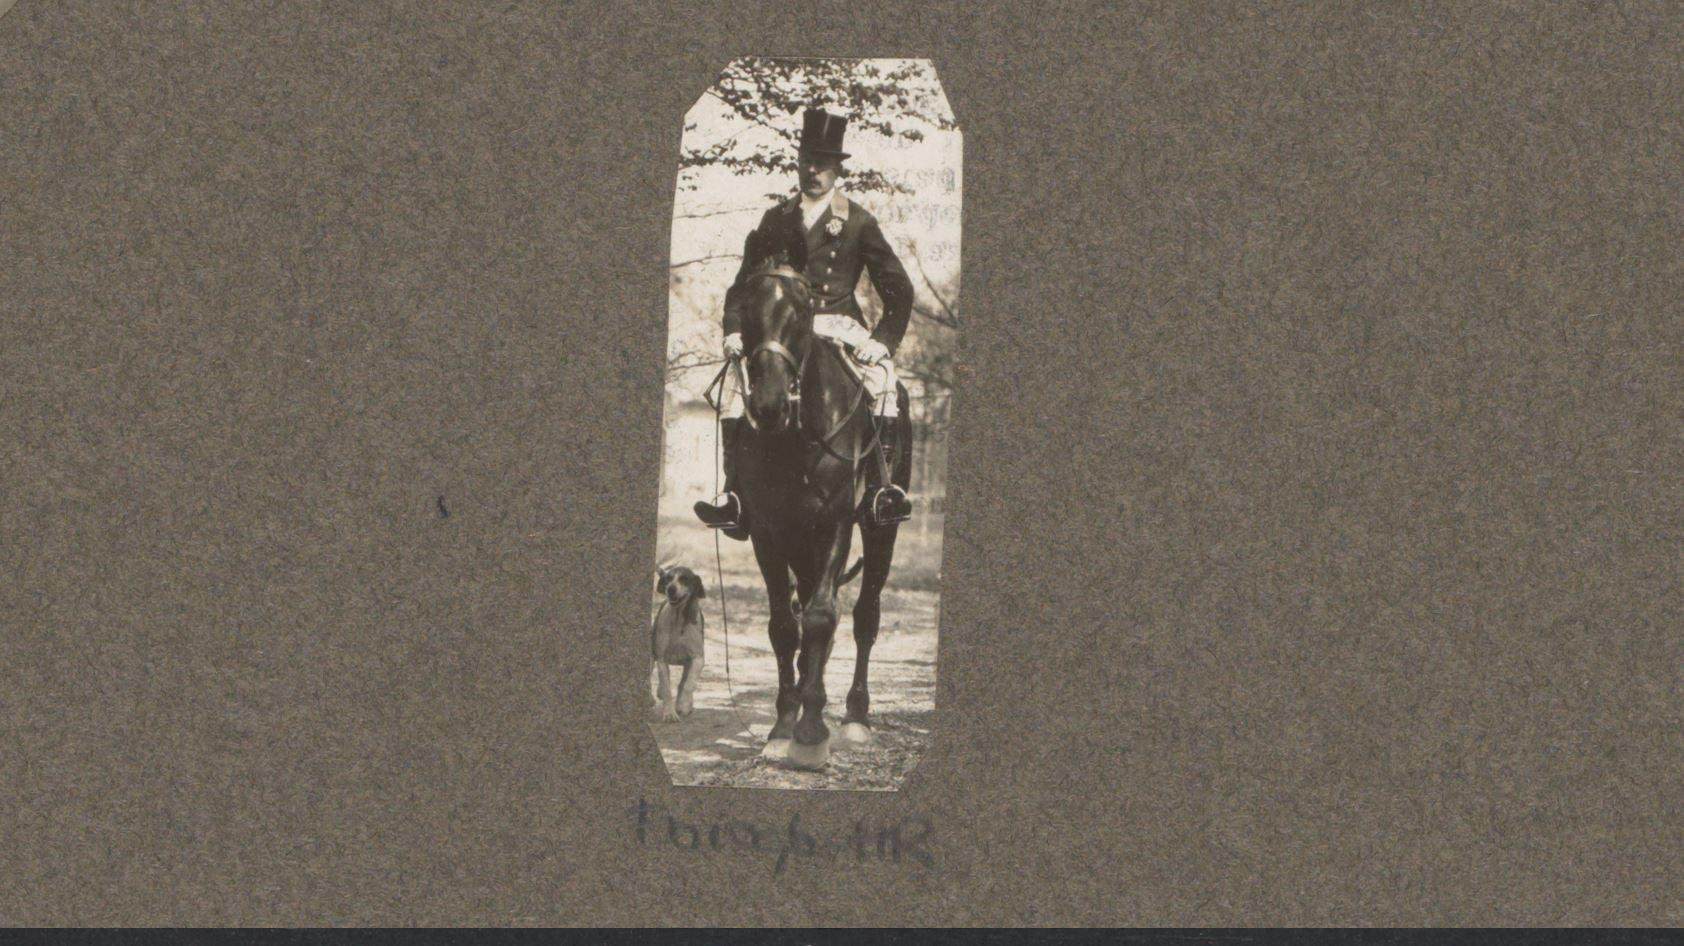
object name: photograph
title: Ruitertafereel op Koninklijke Houtvesterij Het Loo: man te paard met hond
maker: Anonymous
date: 1900-1925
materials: photographic support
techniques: gelatin silver print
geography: het loo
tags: riding a horse, ass, or mule; rider, horseman, hunting, chase, hunting dogs, hunting-ground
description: Onderdeel van Fotoalbum van de heer Brams, opperhoutvester van koningin Wilhelmina op Koninklijke Houtvesterij Het Loo.